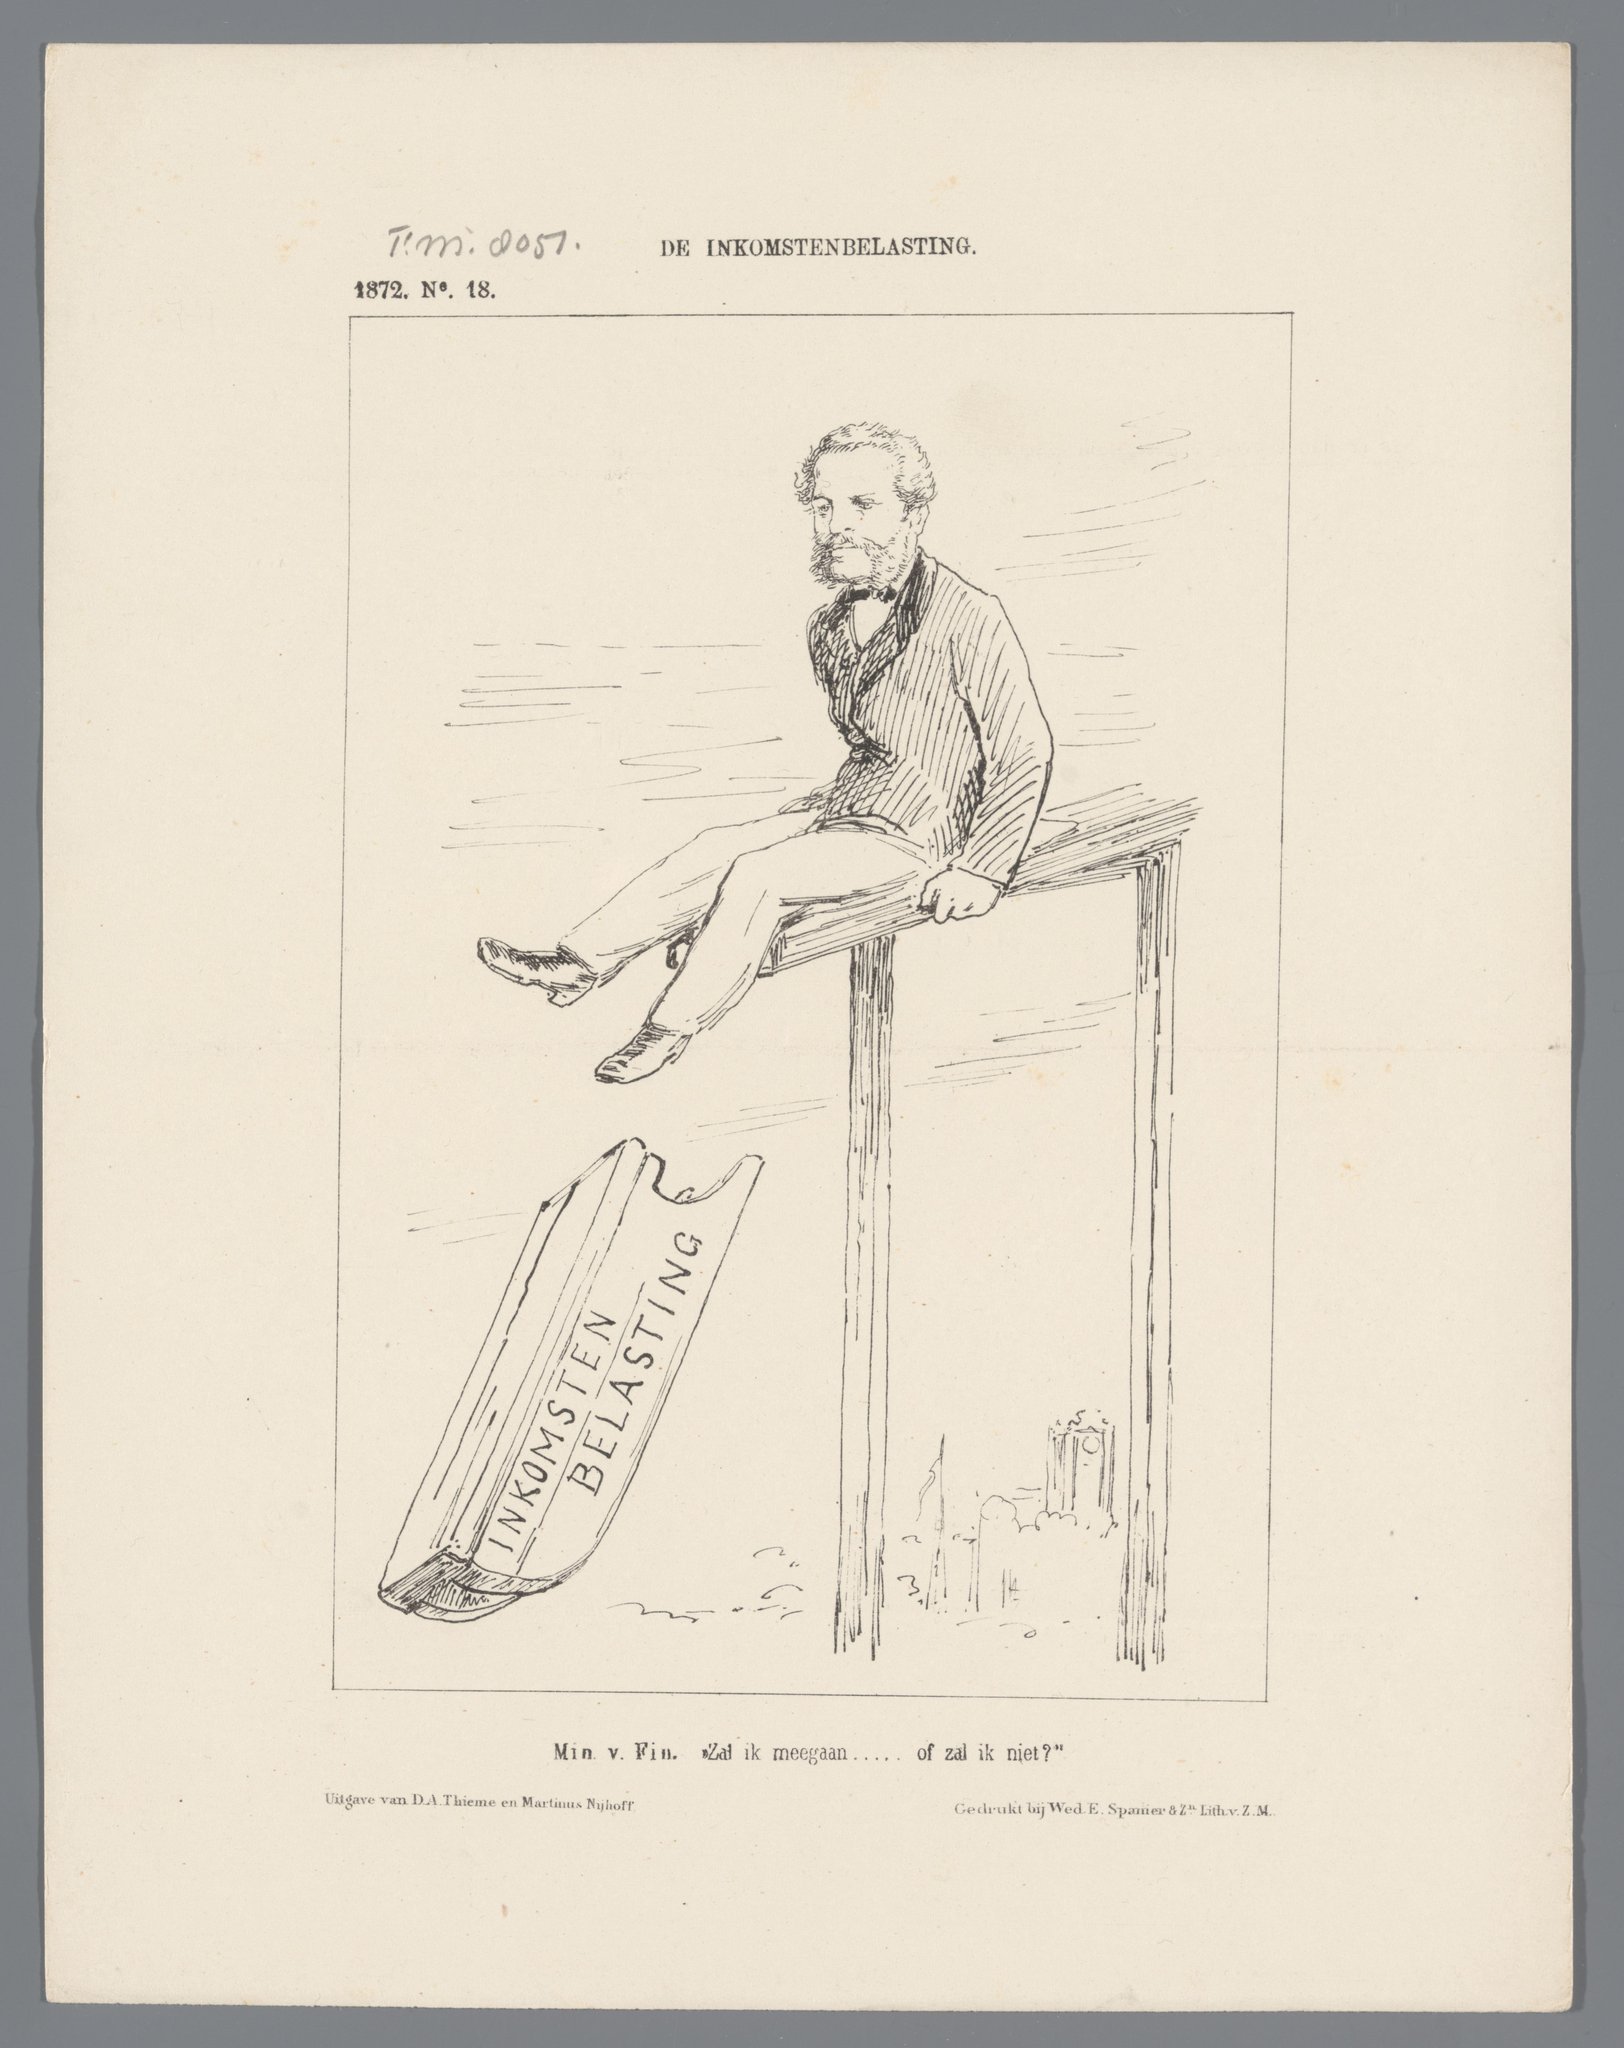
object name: print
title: De inkomstenbelasting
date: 1872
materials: paper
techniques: lithograph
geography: netherlands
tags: pieter blussé van oud-alblas, minister ~ government, small sleigh (winter sports)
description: Spotprent op de Blussé en het laten vallen van zijn wetsontwerp over de inkomstenbelasting. Blussé overweegt of hij zijn vallende slee achterna zal gaan (zie plaat nr. 10). Plaat verschenen bij het weekblad De Nederlandsche Spectator, nr. 18, 1872.